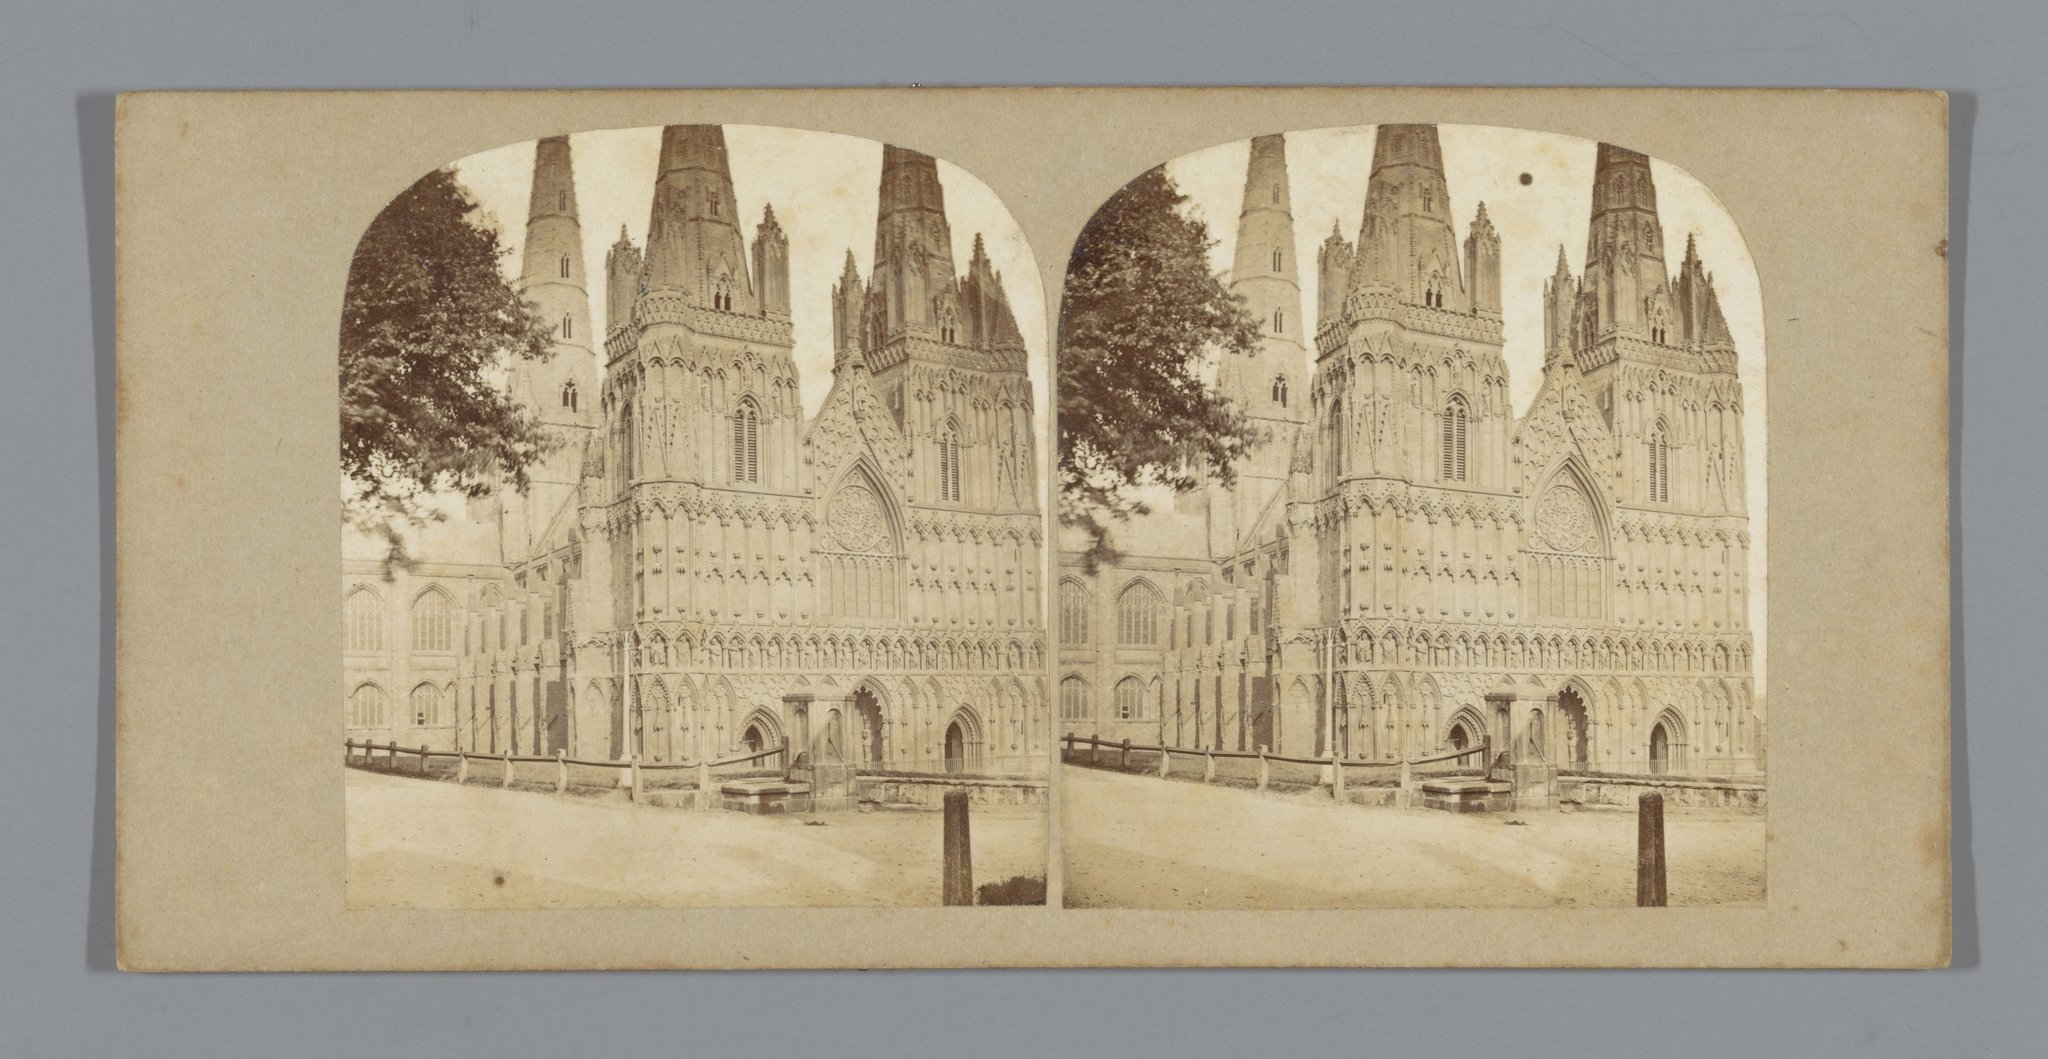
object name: stereograph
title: Façade van de kathedraal van Lichfield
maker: Anonymous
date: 1850-1880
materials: cardboard, photographic support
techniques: albumen print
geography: lichfield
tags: parts of church exterior and annexes: façade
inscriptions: number: ‘No. 249, 251, 252, 253.’